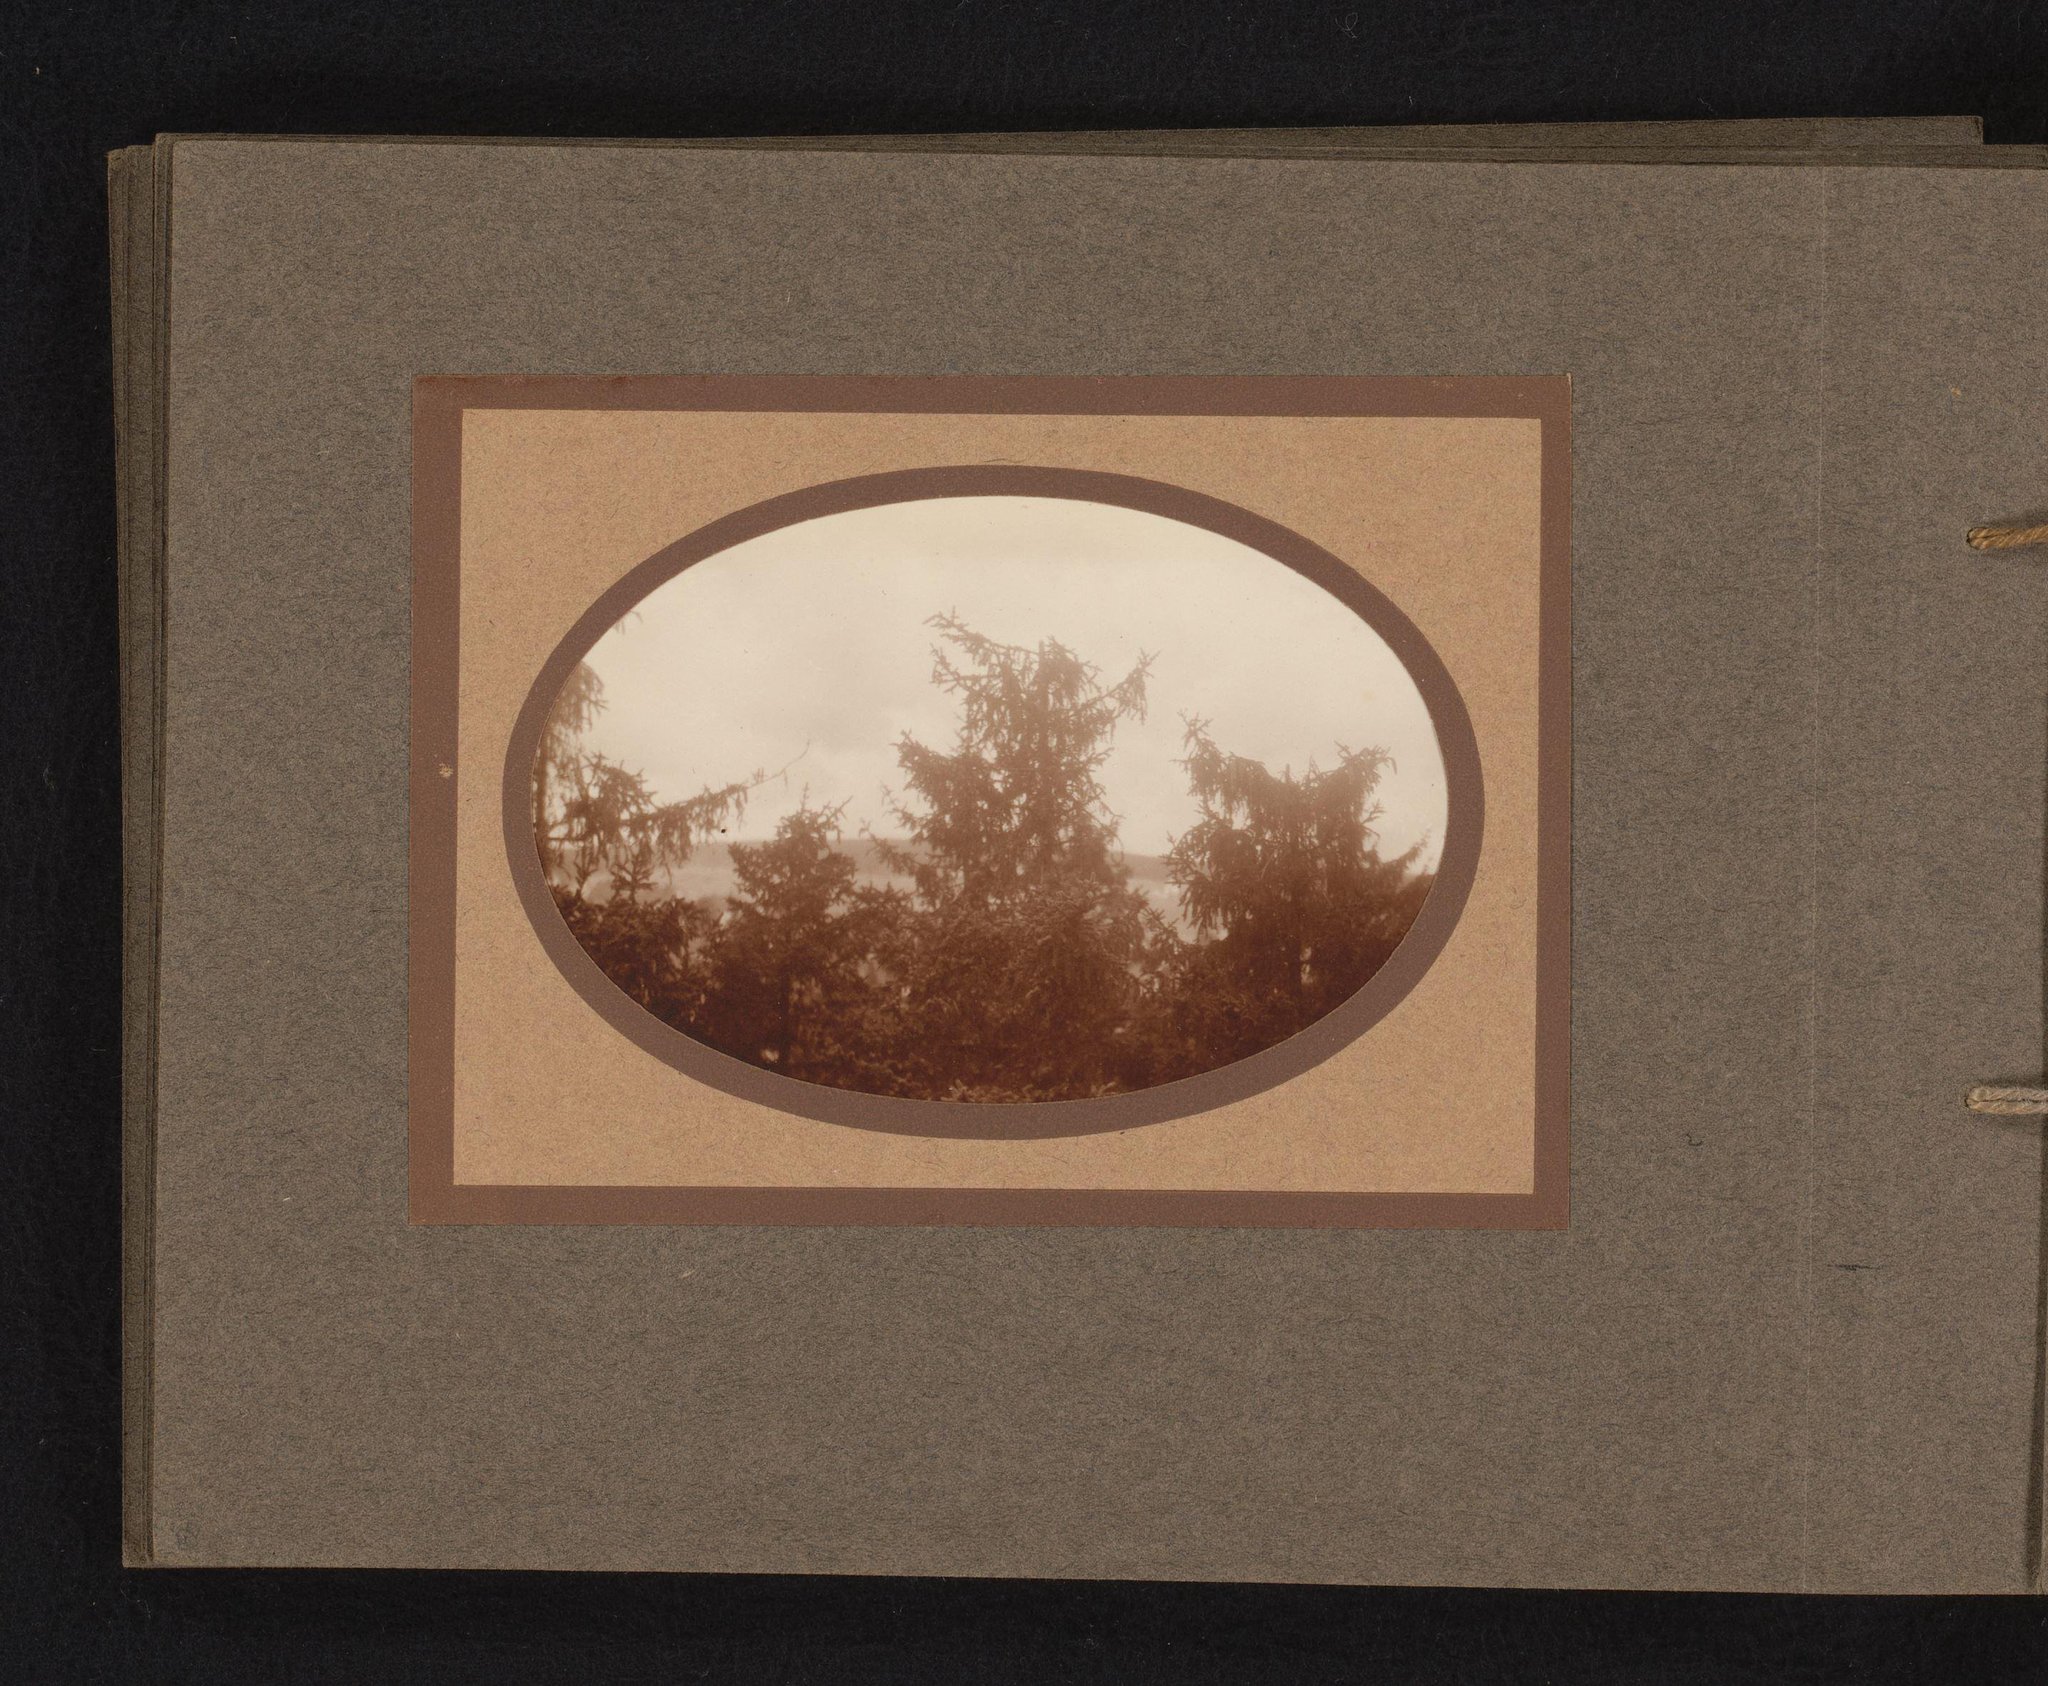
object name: photograph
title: Bomen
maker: Anonymous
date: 1880-1930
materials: cardboard, photographic support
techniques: collodion silver print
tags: trees